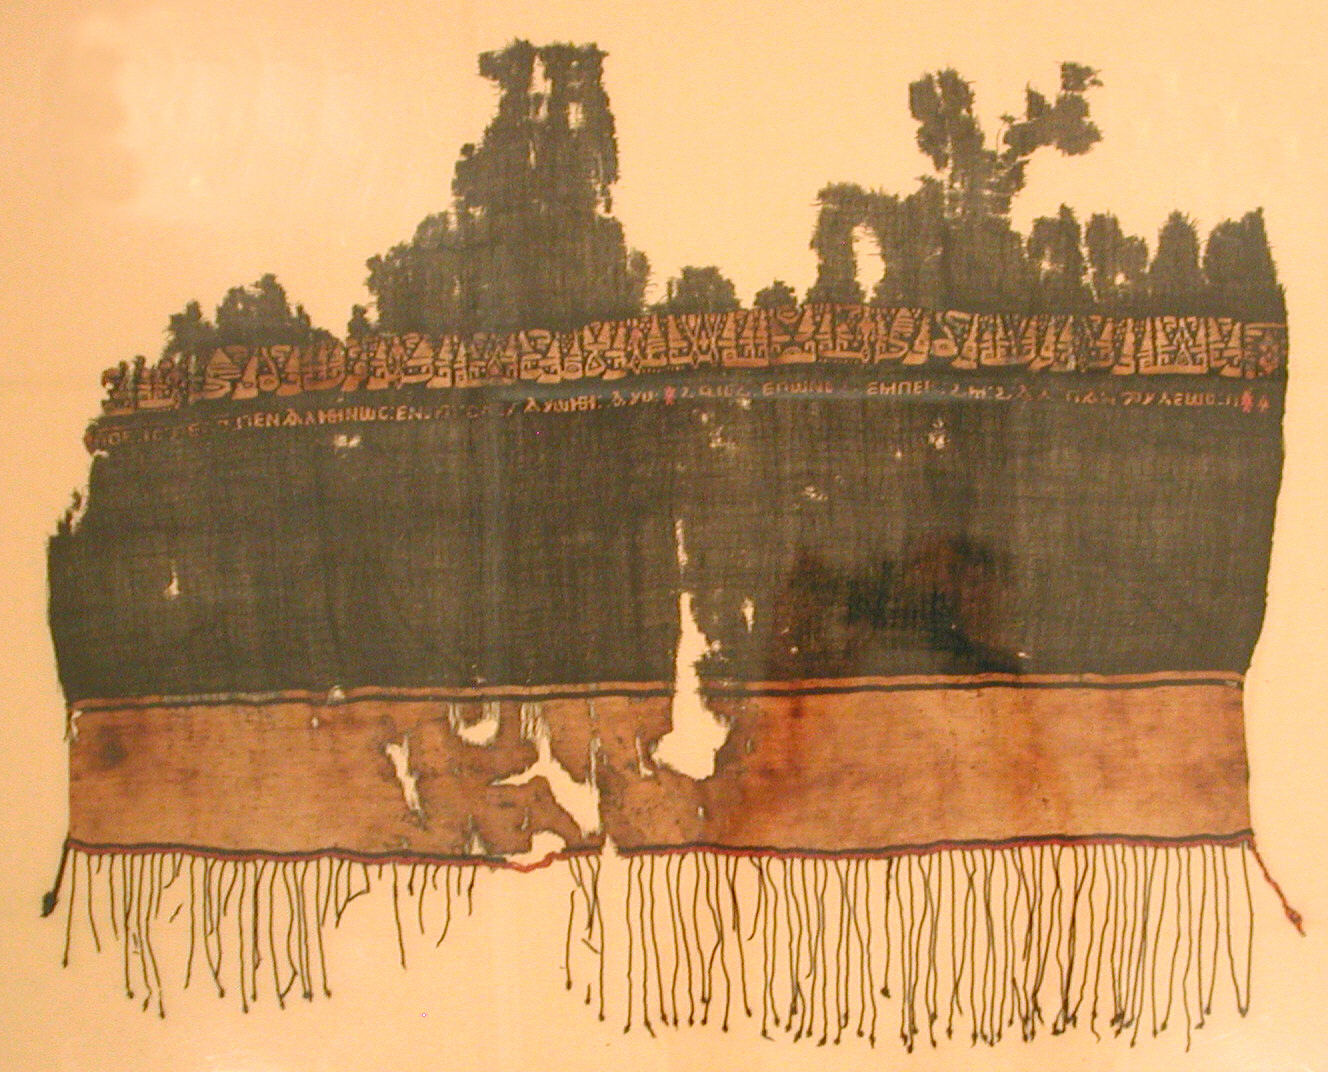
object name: textile fragment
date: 801-1000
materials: linen, wool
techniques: weave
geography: egypt